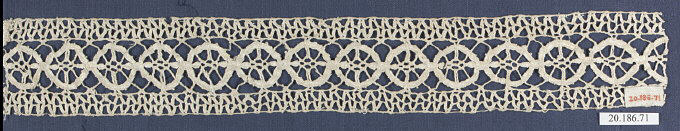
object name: insertion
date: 1501-1600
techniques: lace